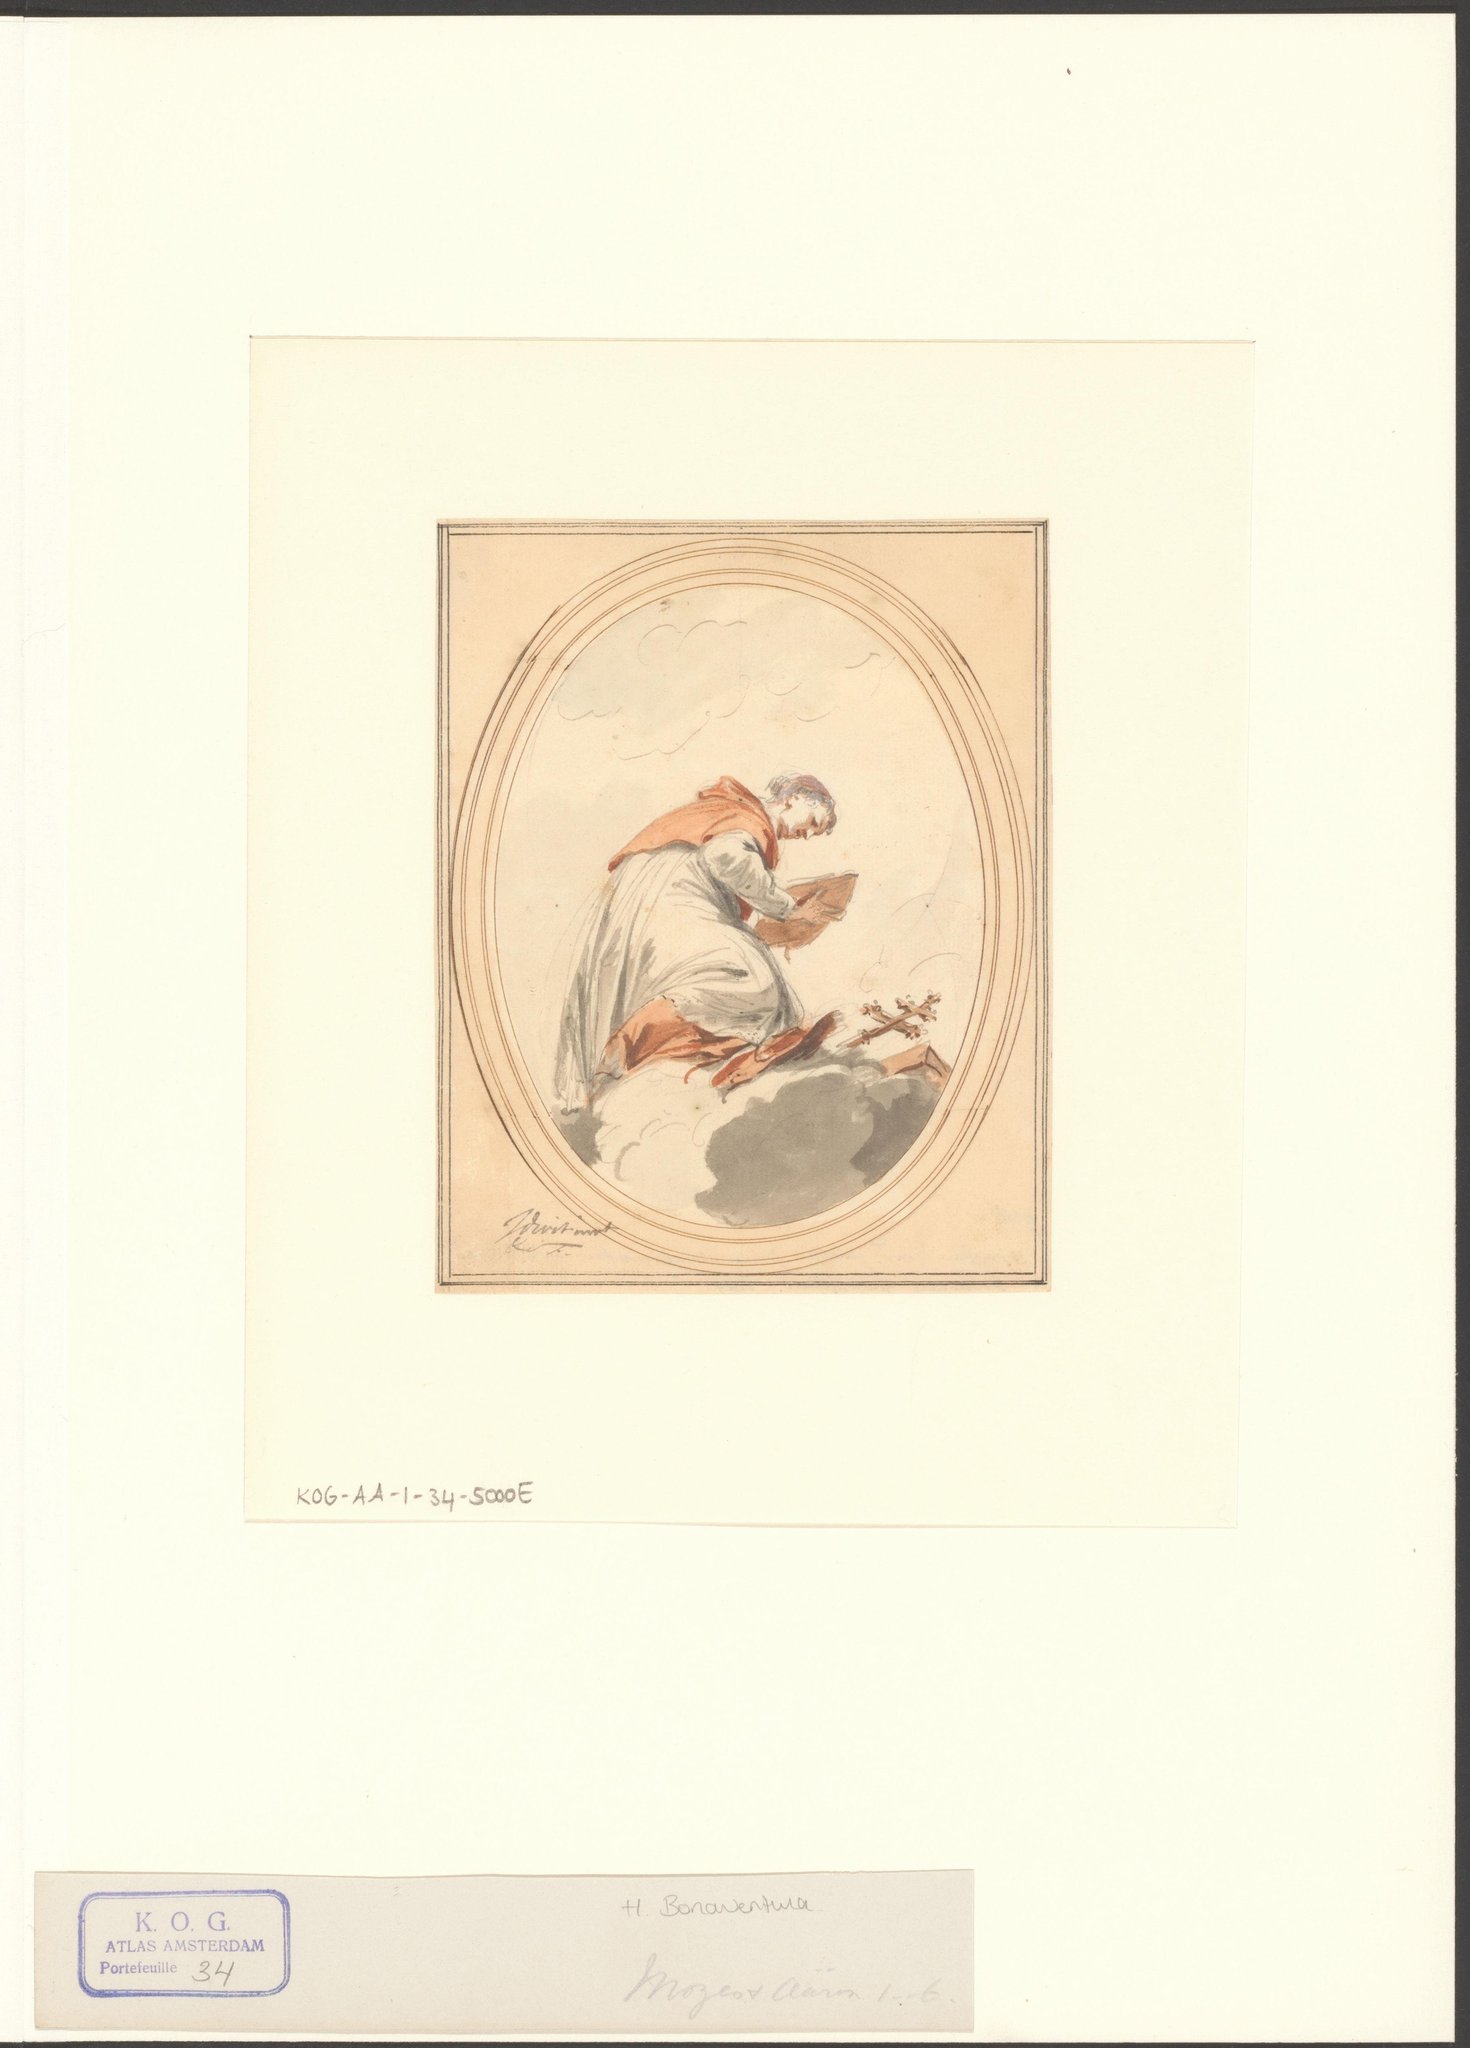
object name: drawing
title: Compositie, mogelijk het plafond van de Mozes en Aäronkerk met de heilige Bonaventura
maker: jacob de wit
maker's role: draughtsman, painter, print maker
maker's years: 1695-1754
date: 1705-1754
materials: paint, ink, paper, pencil, watercolor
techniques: brush, pen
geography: amsterdam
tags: bonaventura, cardinal bishop of albano and minister general of the franciscan order; possible attributes: book, cardinal's hat (sometimes hanging from a tree), crucifix (sometimes flowering)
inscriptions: collector's mark: ‘34’ Lugt 1641b, inscription: ‘voorden eerwd paetter Johannes raedemacker opsijn [...]d. / biblioteca geschildert 17[...]’, signature: ‘JdWit inv’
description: Onderwerpsrubriek binnen de Atlas Amsterdam: Begijnhof, t/m Petrus en Paulus.